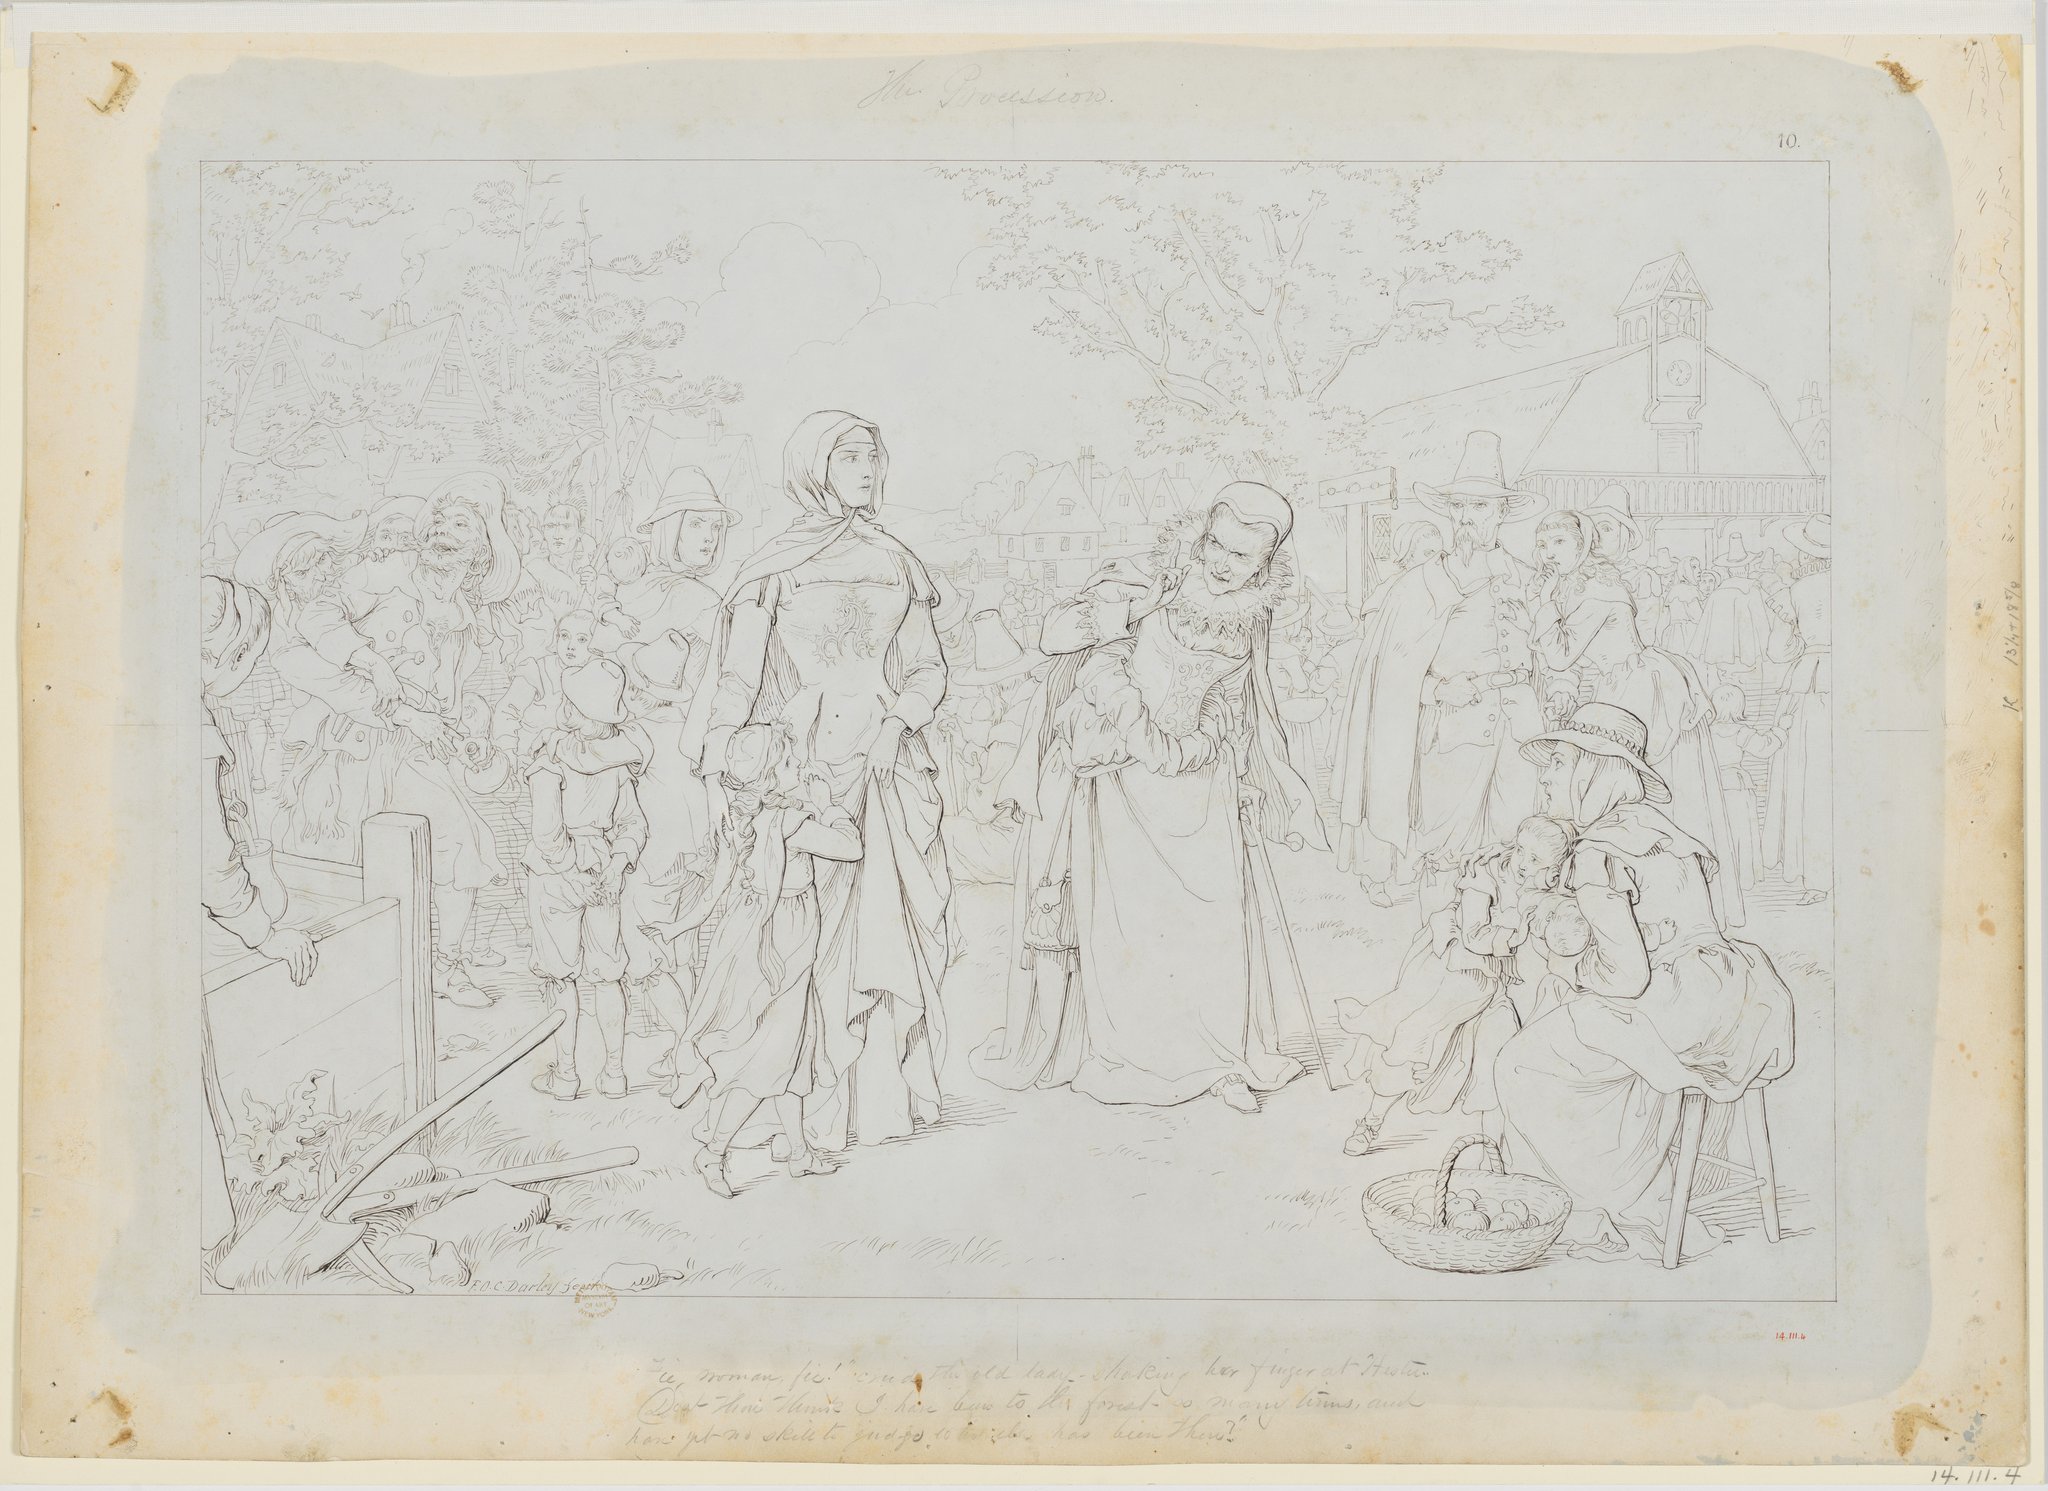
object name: drawing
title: The Procession, from Nathaniel Hawthorne's "The Scarlet Letter"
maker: felix octavius carr darley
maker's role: artist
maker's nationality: american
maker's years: 1822-1888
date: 1879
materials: graphite, ink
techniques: pen, wash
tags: girls,infants,men,women